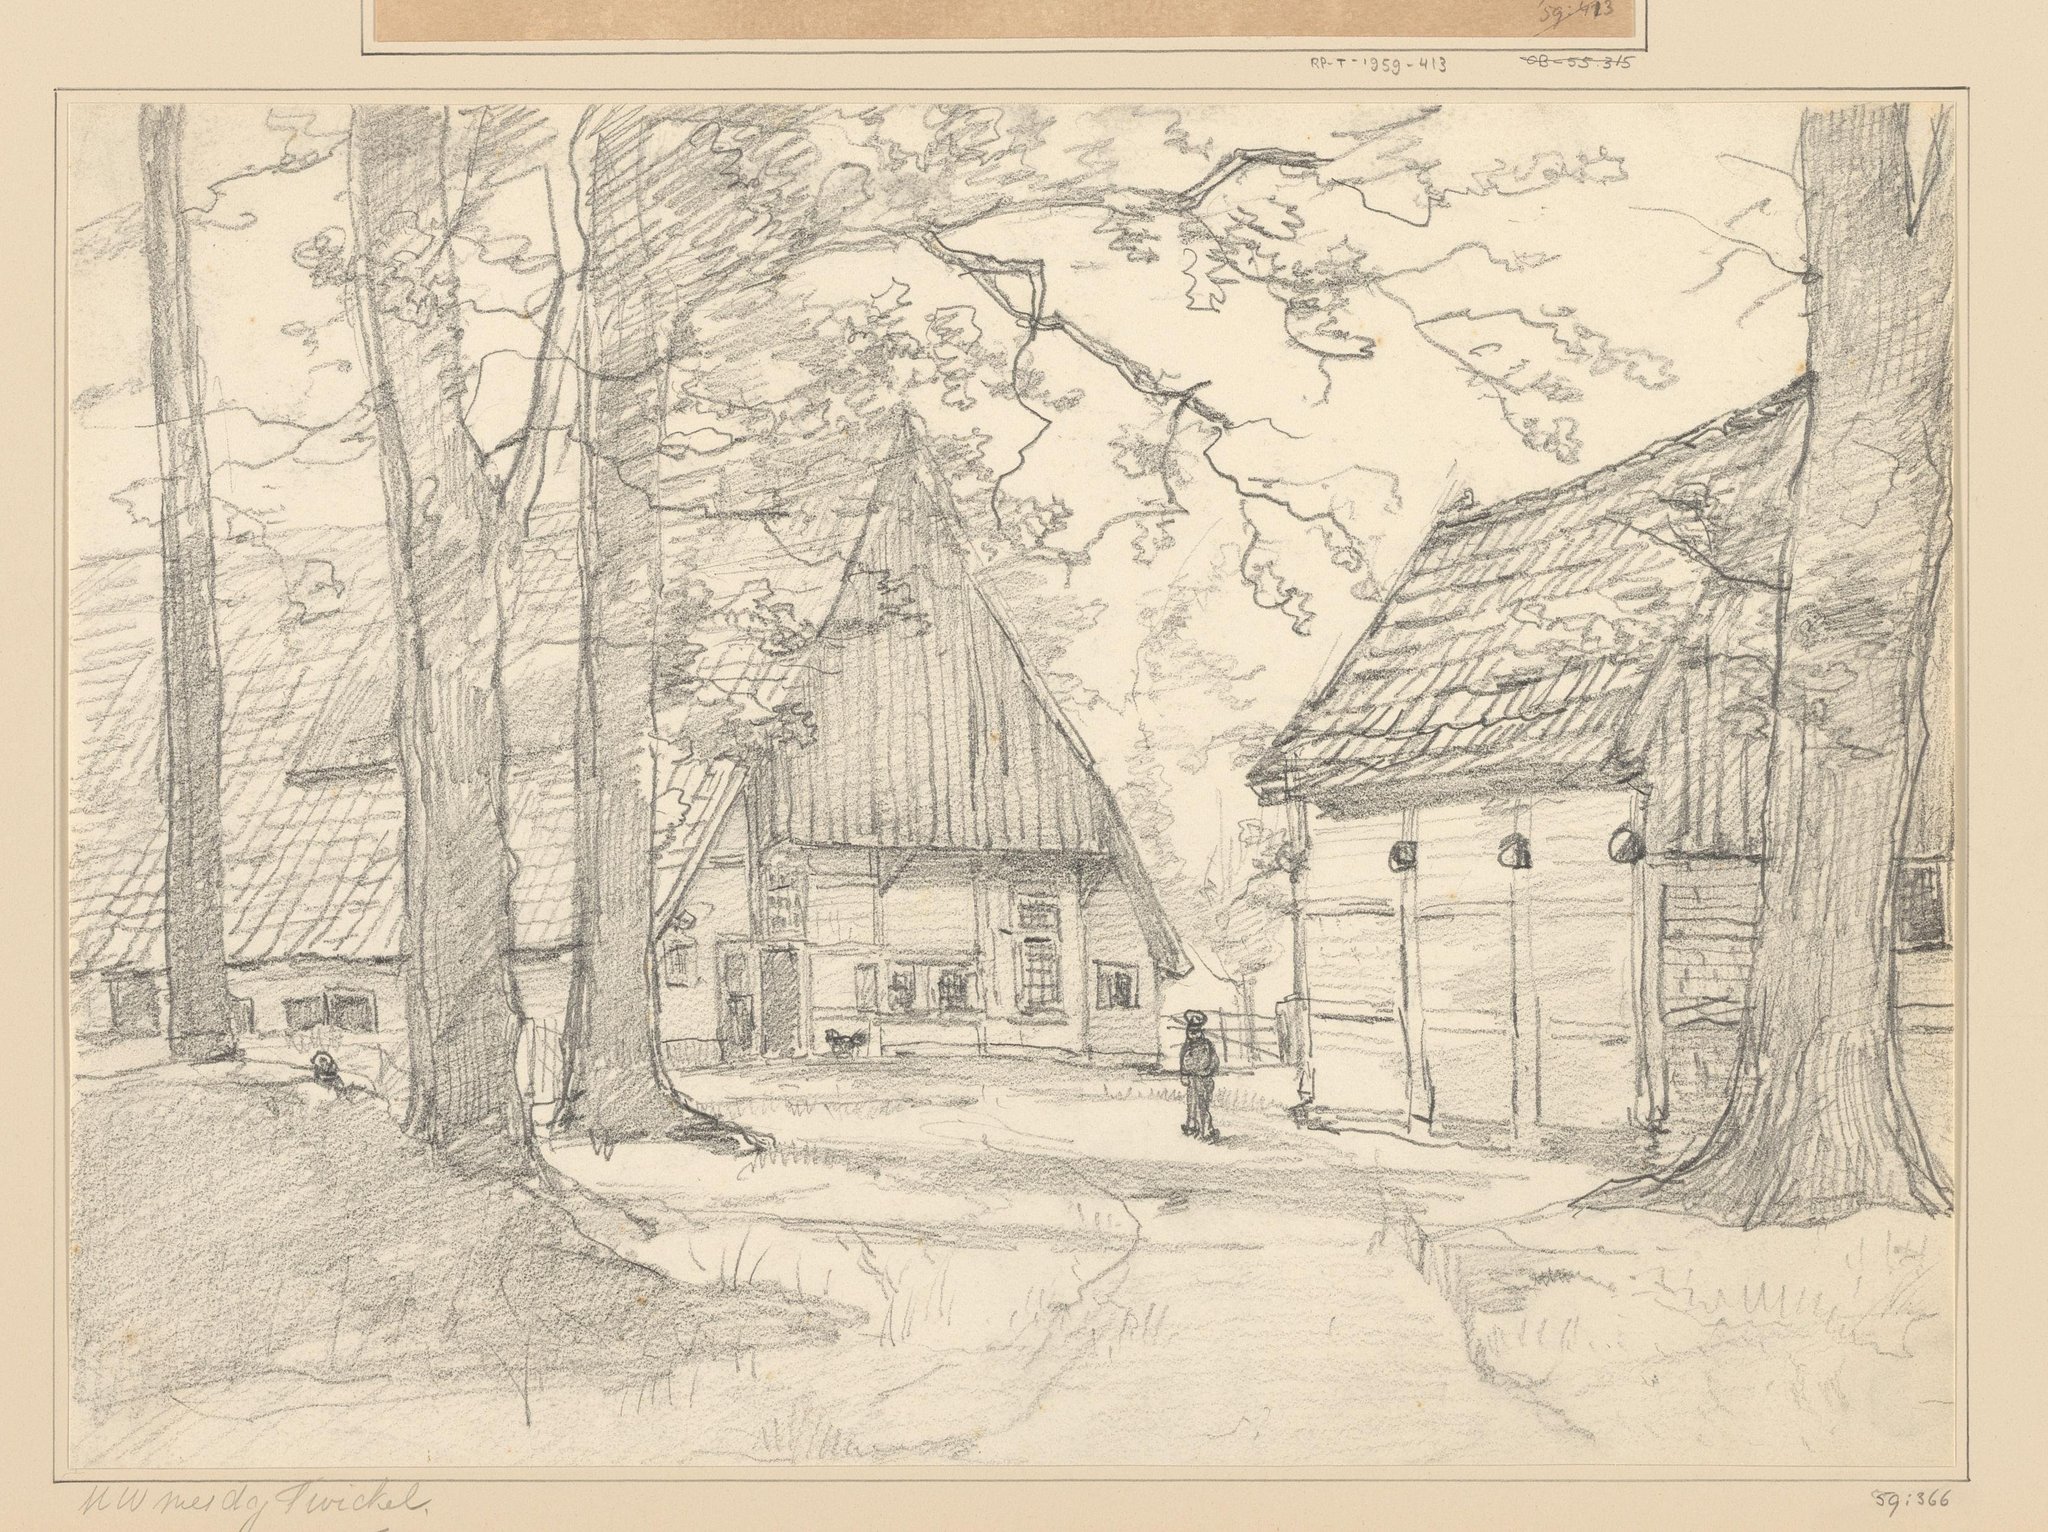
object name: drawing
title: Gezicht op een boerderij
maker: hendrik willem mesdag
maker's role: draughtsman, painter, print maker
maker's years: 1831-1915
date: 1841-1915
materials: chalk, paper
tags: farm (building)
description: Mogelijk op het landgoed van Kasteel Twickel.